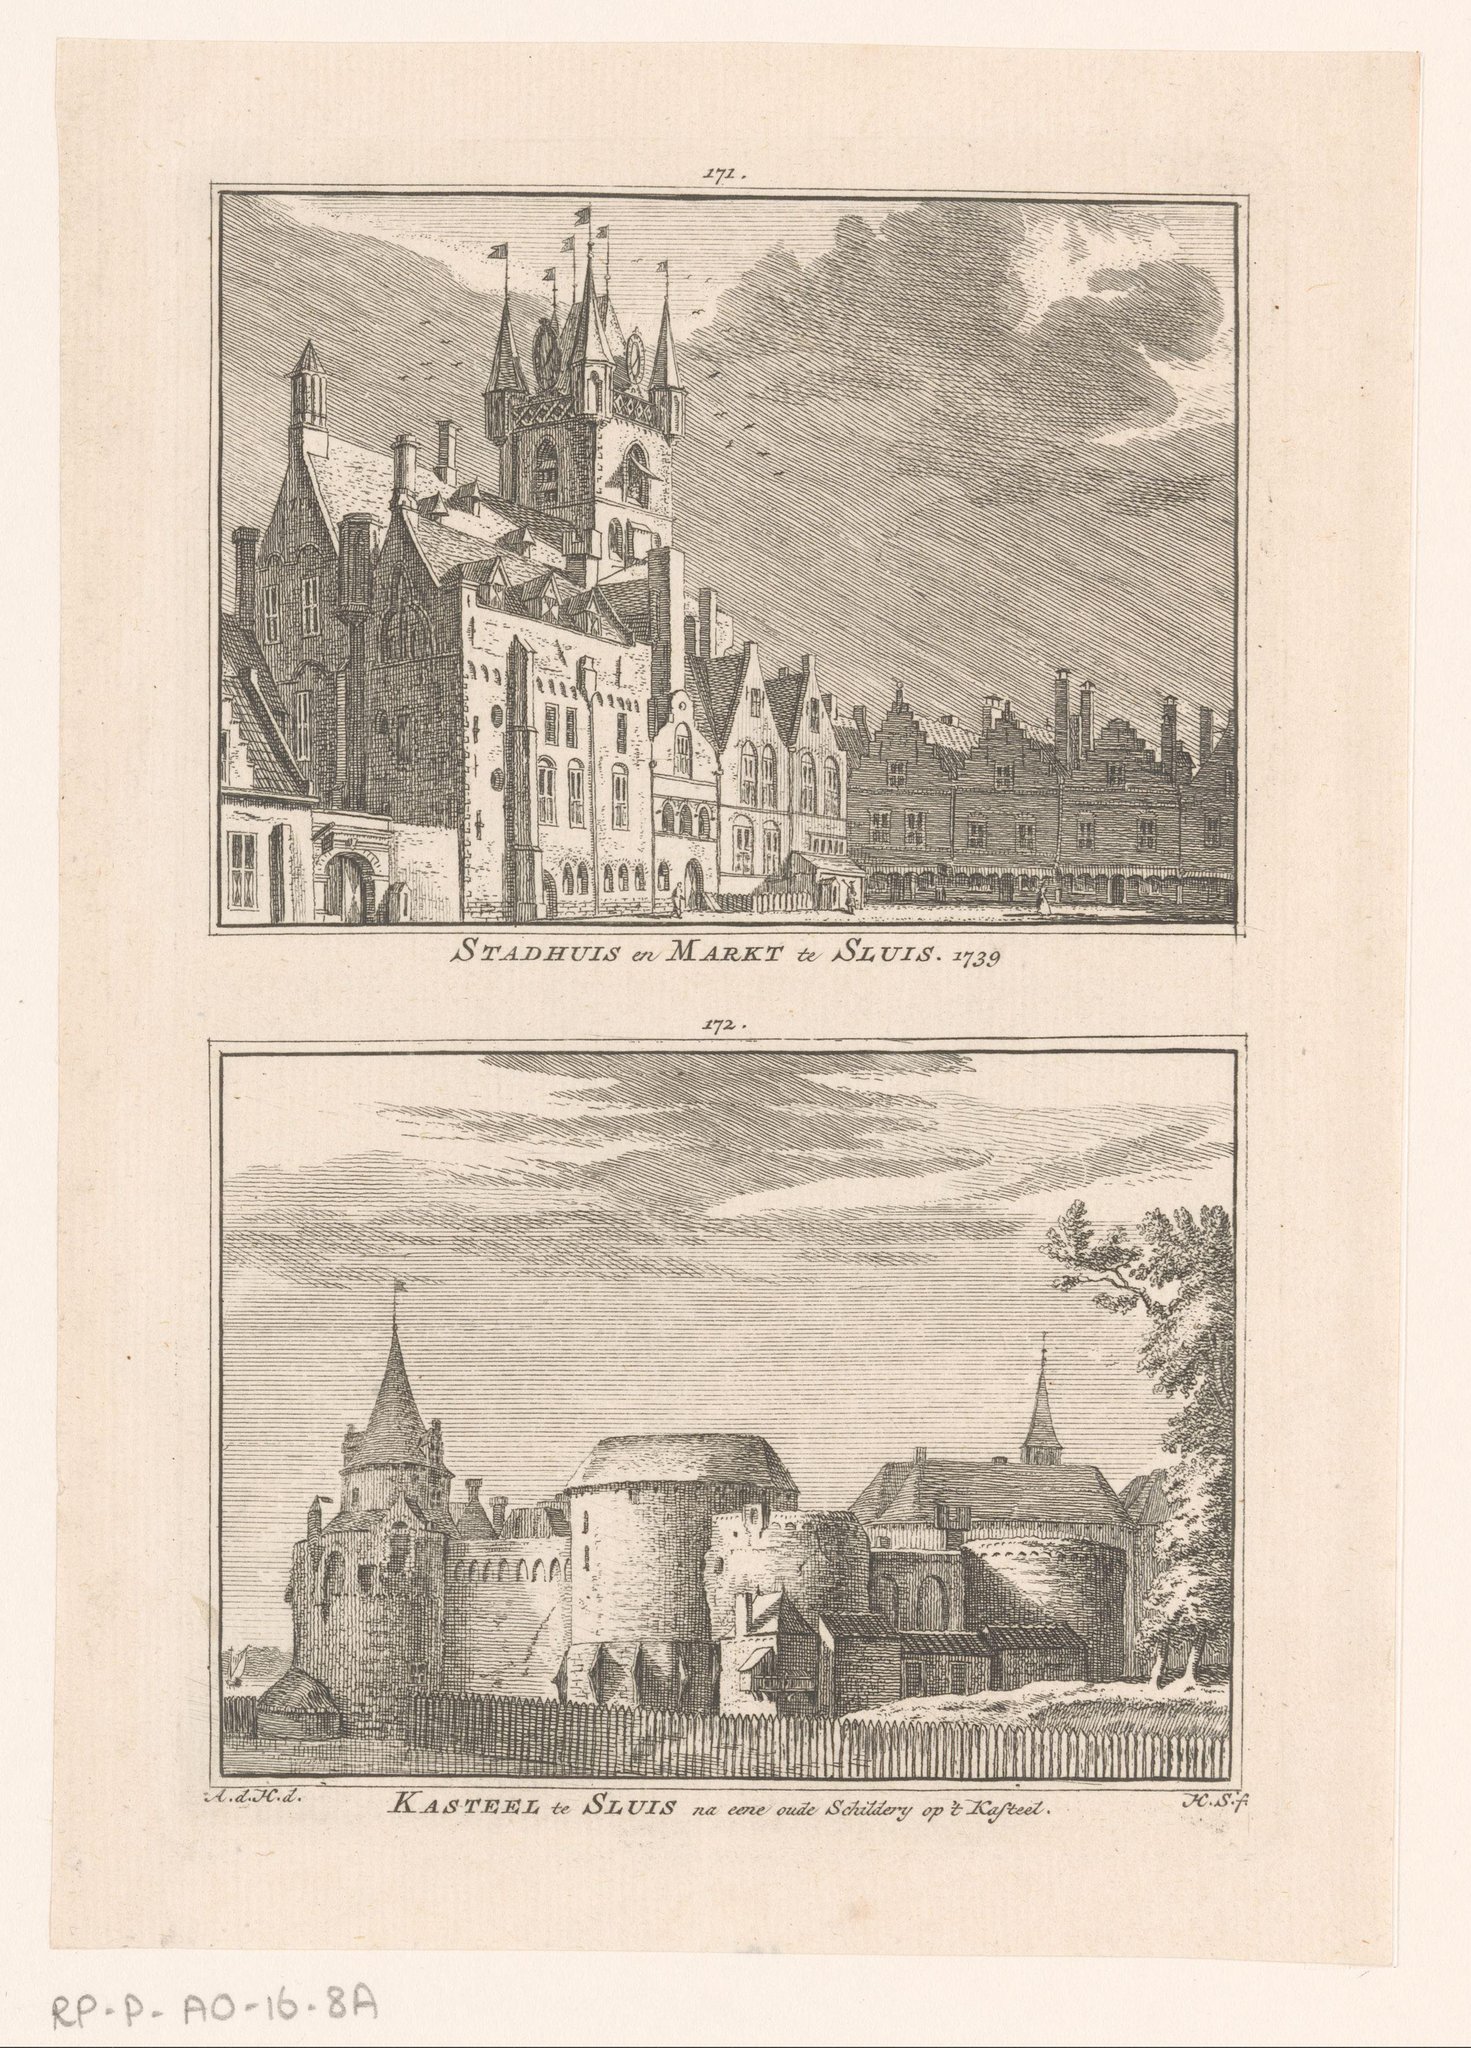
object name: book illustration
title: Gezicht op het stadhuis en het Kasteel van Sluis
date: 1746-1792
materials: paper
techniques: engraving, etching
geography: haarlem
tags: castle, townhall, market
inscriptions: collector's mark: Lugt 2228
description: Prent ook gebruikt in: Het verheerlykt Nederland of kabinet van hedendaagsche gezigten van steden, dorpen […]. 9 delen. Amsterdam: Isaak Tirion en weduwe Isaak Tirion, 1745-1774, dl. 2 (1746), ill. 171-172. Of in: Nederlandsche tafereelen; of eene keurige verzameling van negen honderd fraaije gezigten van steden, dorpen, sloten, oudheden [….]. 9 delen. Amsterdam: Jan de Groot, 1792, dl. 2, ill. 171-172.